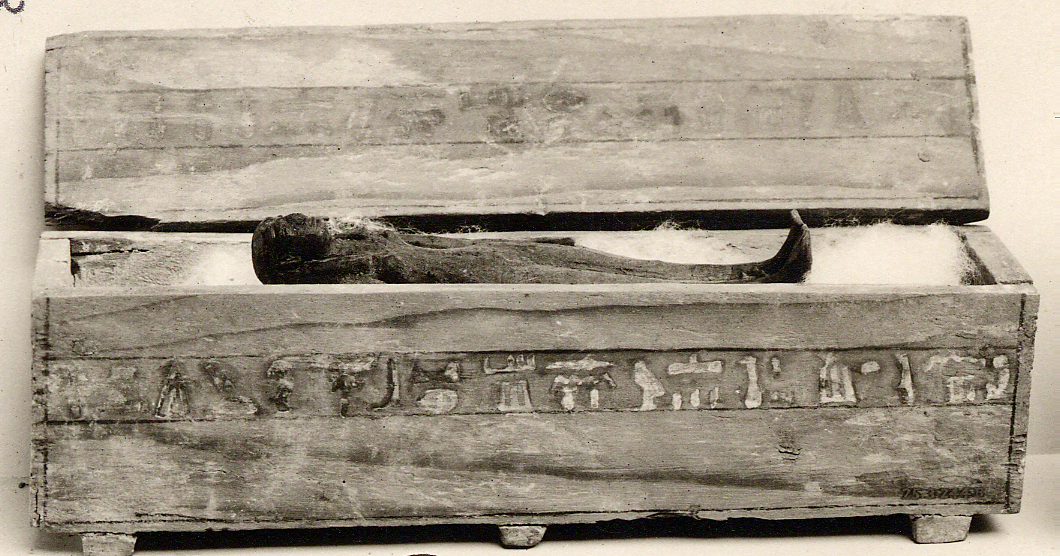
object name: miniature coffin, queen neferu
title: Miniature coffin for funerary figurine of Queen Neferu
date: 2051-2030 BCE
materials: wood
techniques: painting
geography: egypt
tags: coffins